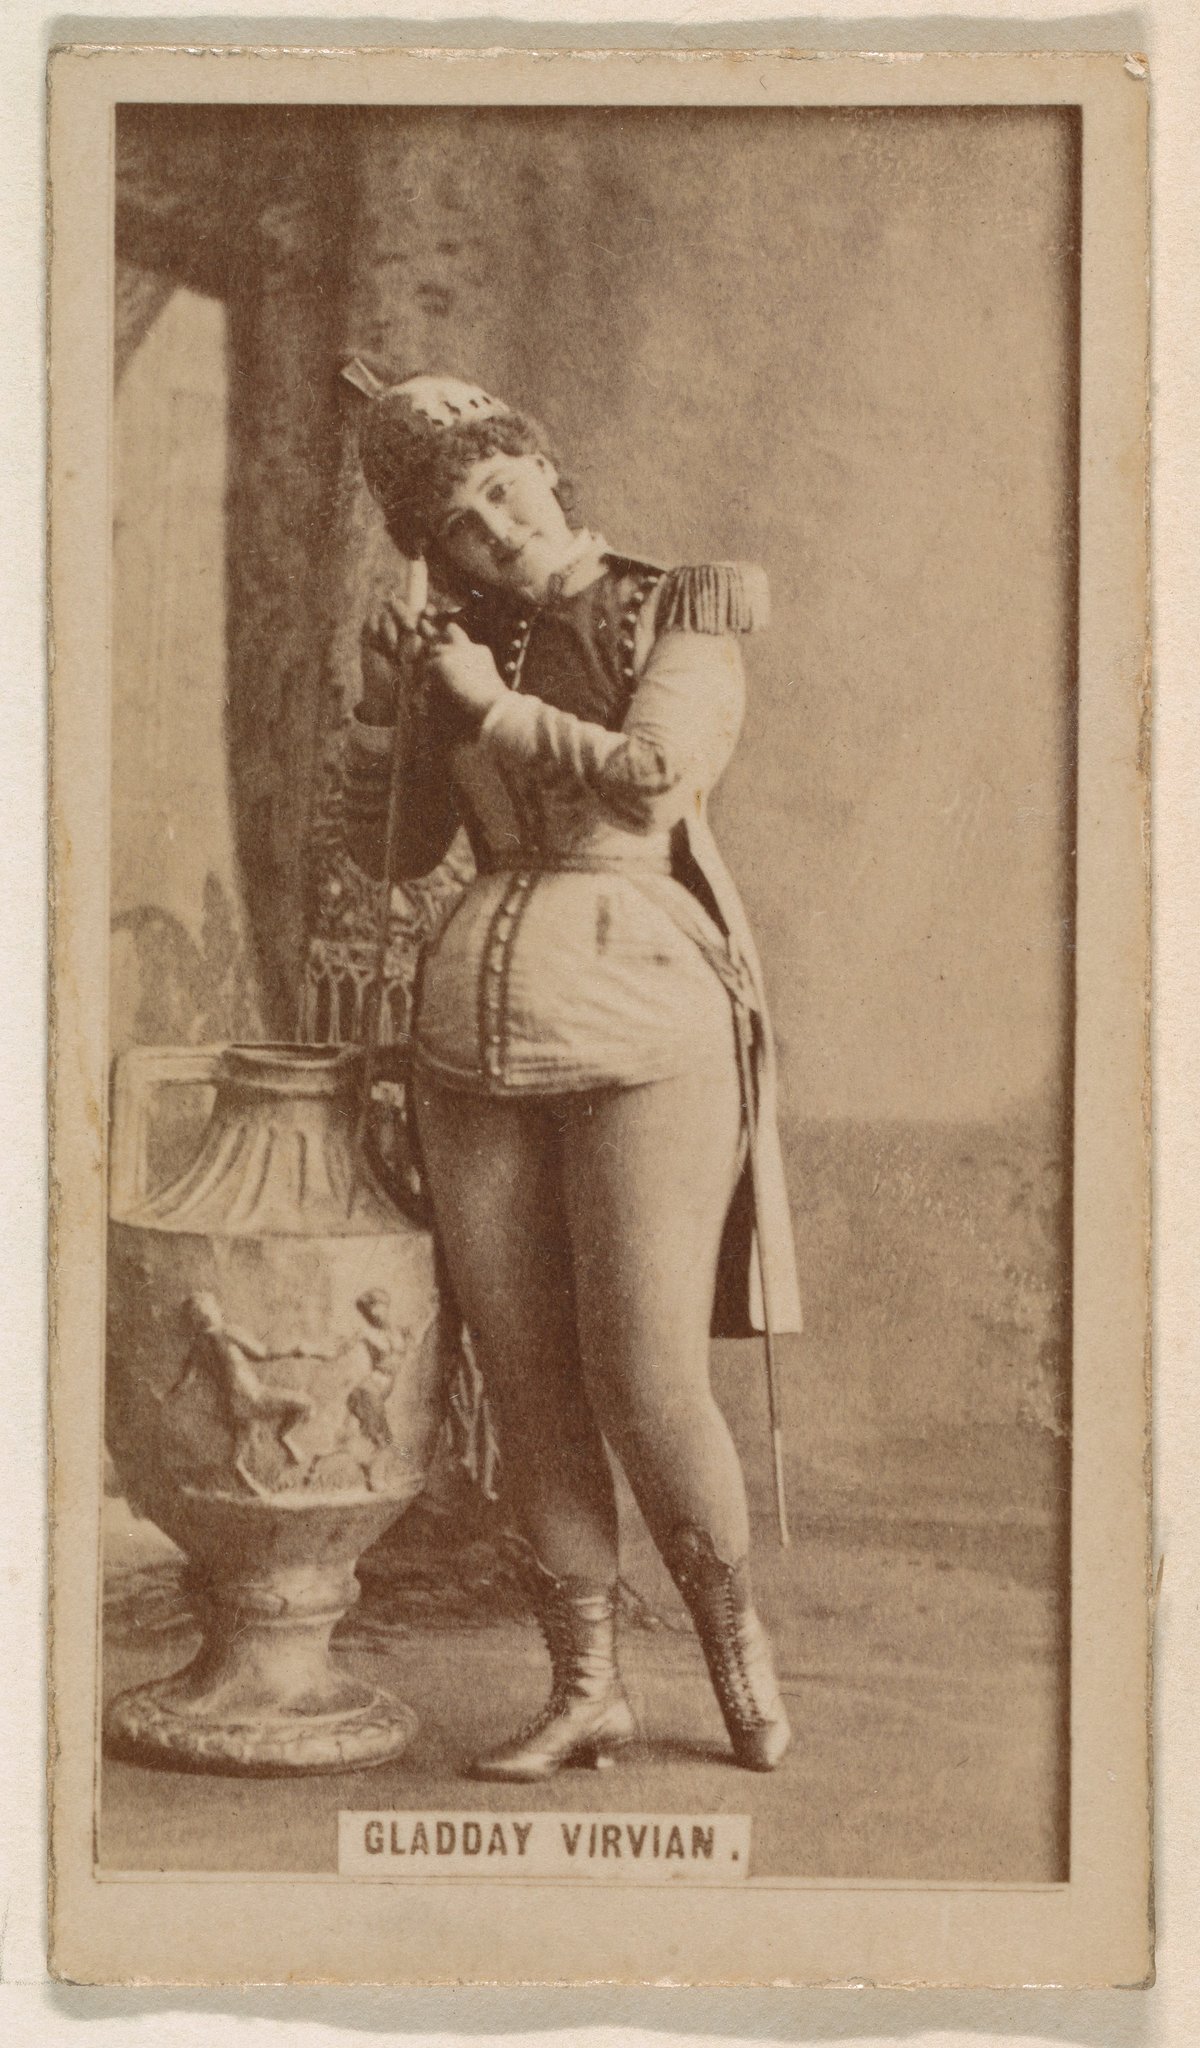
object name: photograph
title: Gladday Virvian, from the Actresses series (N245) issued by Kinney Brothers to promote Sweet Caporal Cigarettes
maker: kinney brothers tobacco company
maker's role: publisher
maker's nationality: american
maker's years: 1869-2011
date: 1890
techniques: albumen silver print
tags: portraits,women,actresses